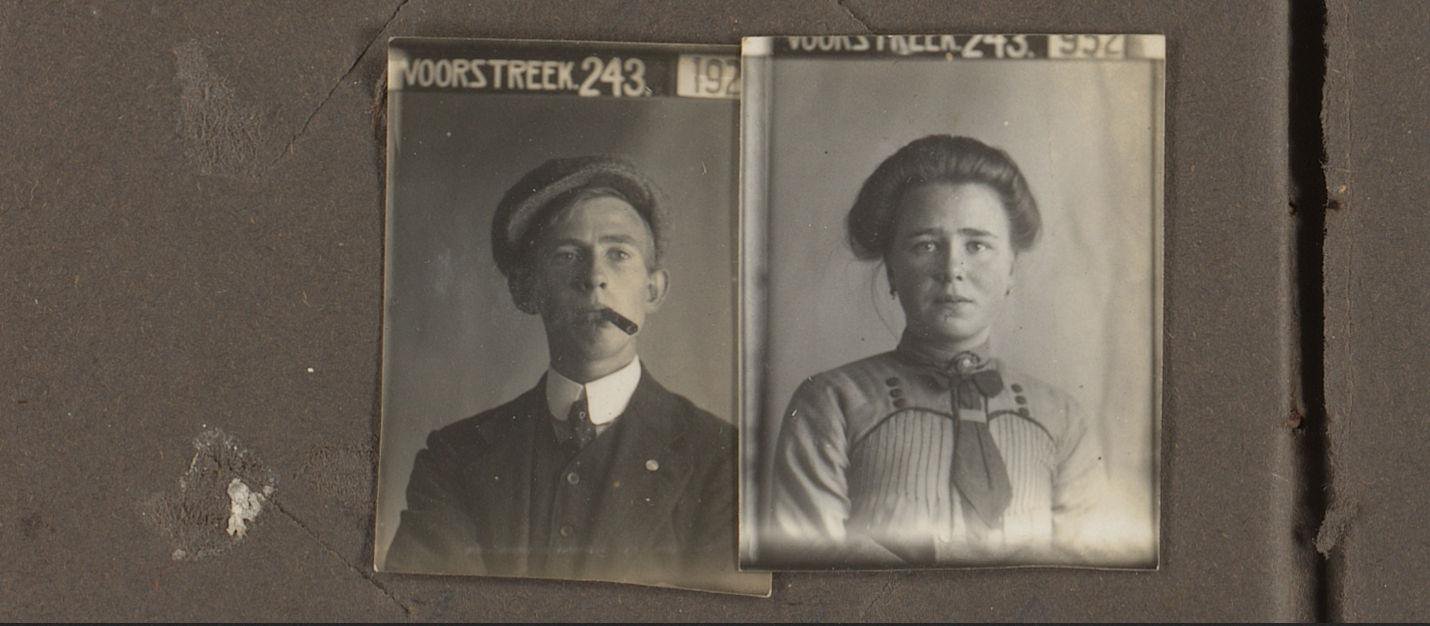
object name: snapshot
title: Portret van een onbekende jonge man met sigaar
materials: paper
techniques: gelatin silver print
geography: leeuwarden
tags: anonymous historical person portrayed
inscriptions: address: ‘VOORSTREEK 243./ 192’